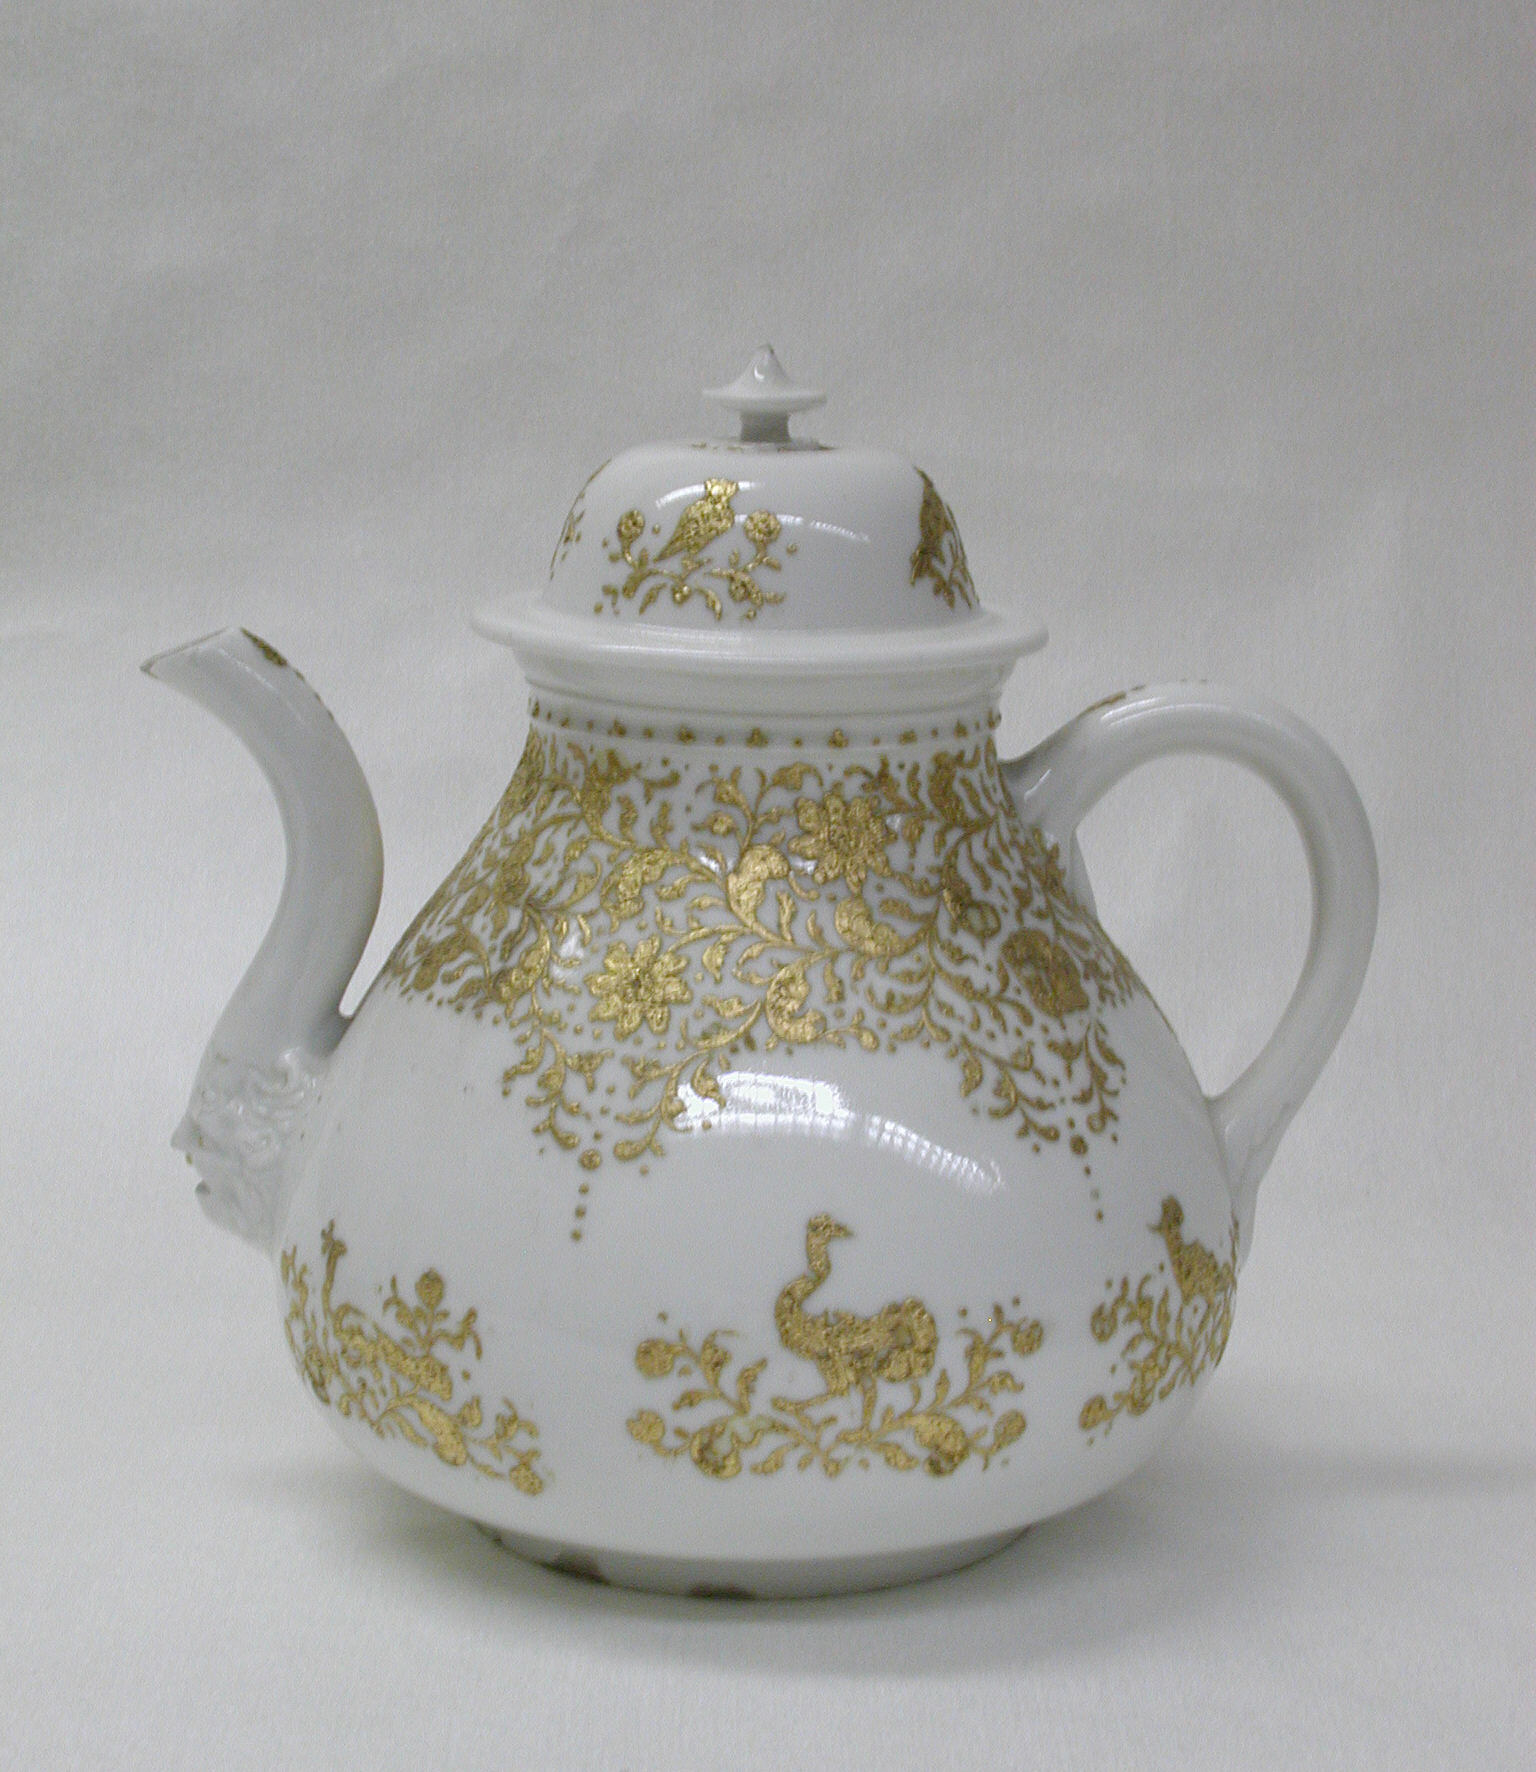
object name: teapot with cover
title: Teapot with cover (part of a service)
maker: meissen manufactory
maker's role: manufactory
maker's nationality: german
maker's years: 1710-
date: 1720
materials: hard paste porcelain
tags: birds,flowers